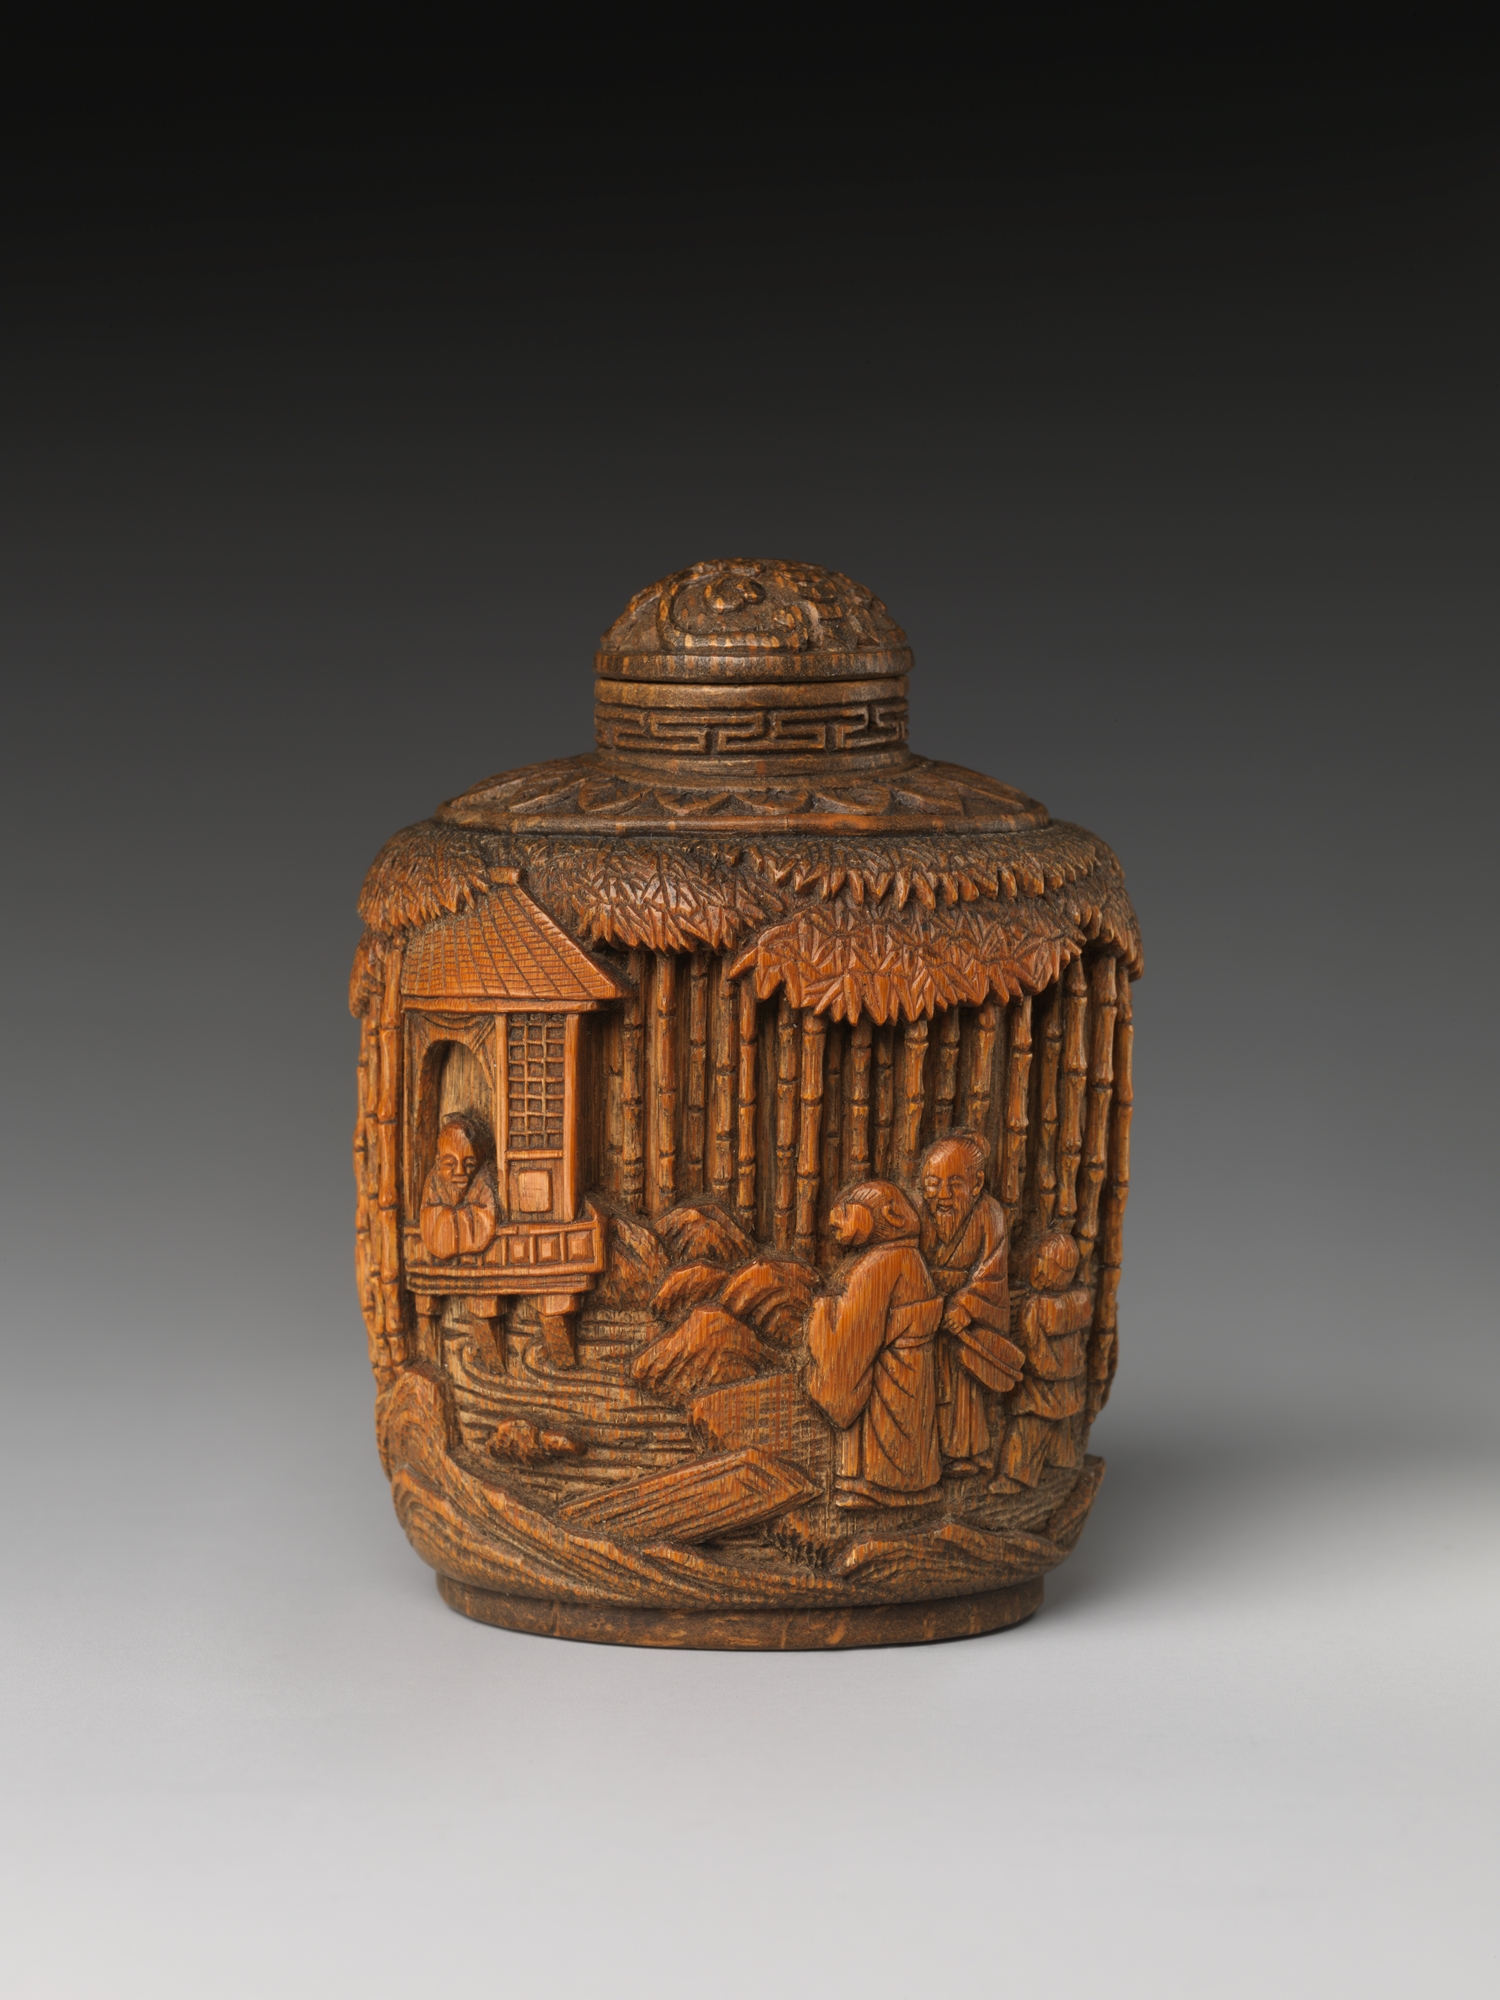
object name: snuff bottle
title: Snuff Bottle with Seven Sages of the Bamboo Grove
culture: chinese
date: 1736-1795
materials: bamboo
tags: human figures,bamboo